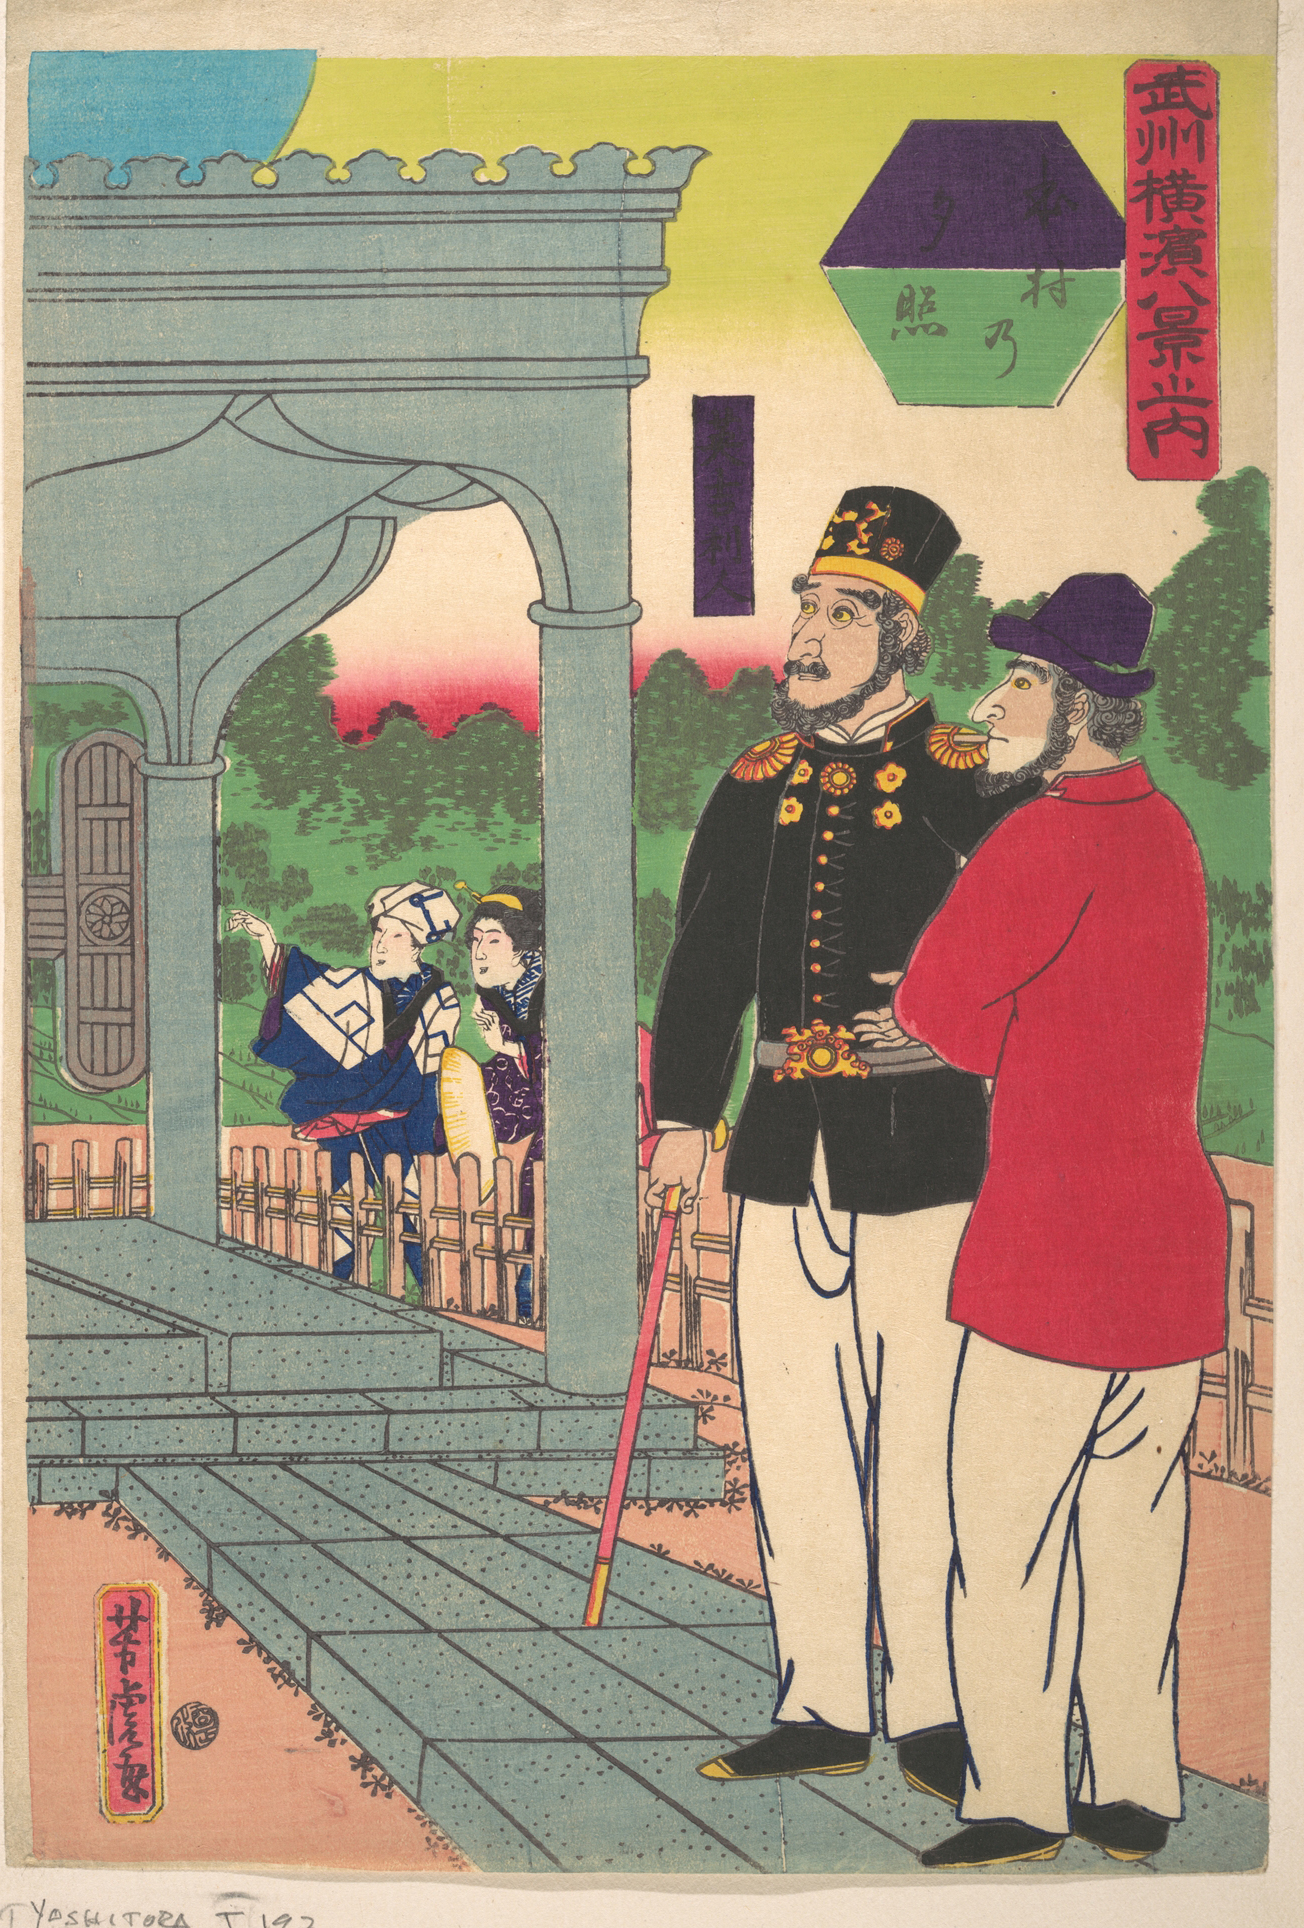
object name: print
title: Evening Glow at Motomura [Two Englishmen looking at the sunset]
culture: japanese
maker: utagawa yoshitora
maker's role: artist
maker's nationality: japanese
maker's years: 1845-1880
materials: ink, paper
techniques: woodblock print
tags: men,women,evening